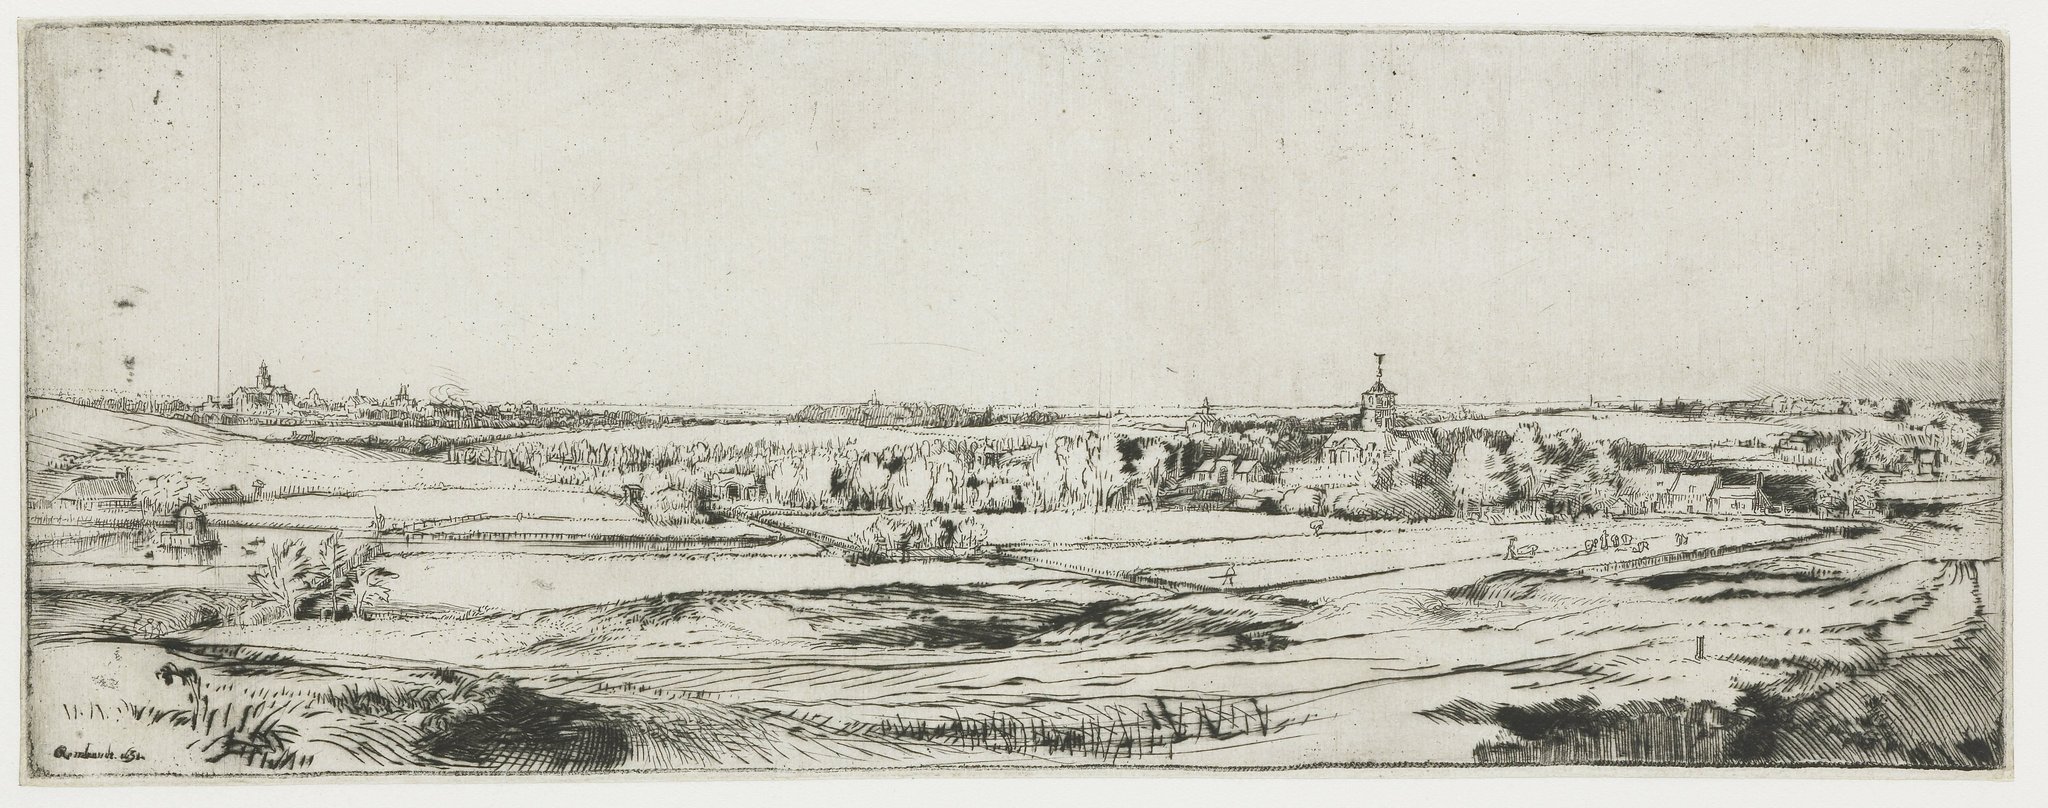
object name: print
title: Panorama near Bloemendaal with the Saxenburg Estate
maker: rembrandt van rijn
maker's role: draughtsman, painter, print maker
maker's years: 1606-1669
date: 1651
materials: paper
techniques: drypoint, etching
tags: saxenburg, bloemendaal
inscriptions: signature and date: ‘Rembrandt. 1651’, inscription: ‘From the John Barnard Colln’, mark: Lugt 2228, inscription: ‘C. 13267’, inscription: ‘K 5011 / C 5309’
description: From 1638 the Saxenburg estate belonged to Christoffel Thijsz, the man from whom Rembrandt bought his house on the Jodenbreestraat. Rembrandt possibly made this print as a gift for his creditor. The panorama of Haarlem and Bloemendaal in the distance cannot be observed in a single glance. Rembrandt may have used numerous sketches to recreate the distant vista in its entirety.